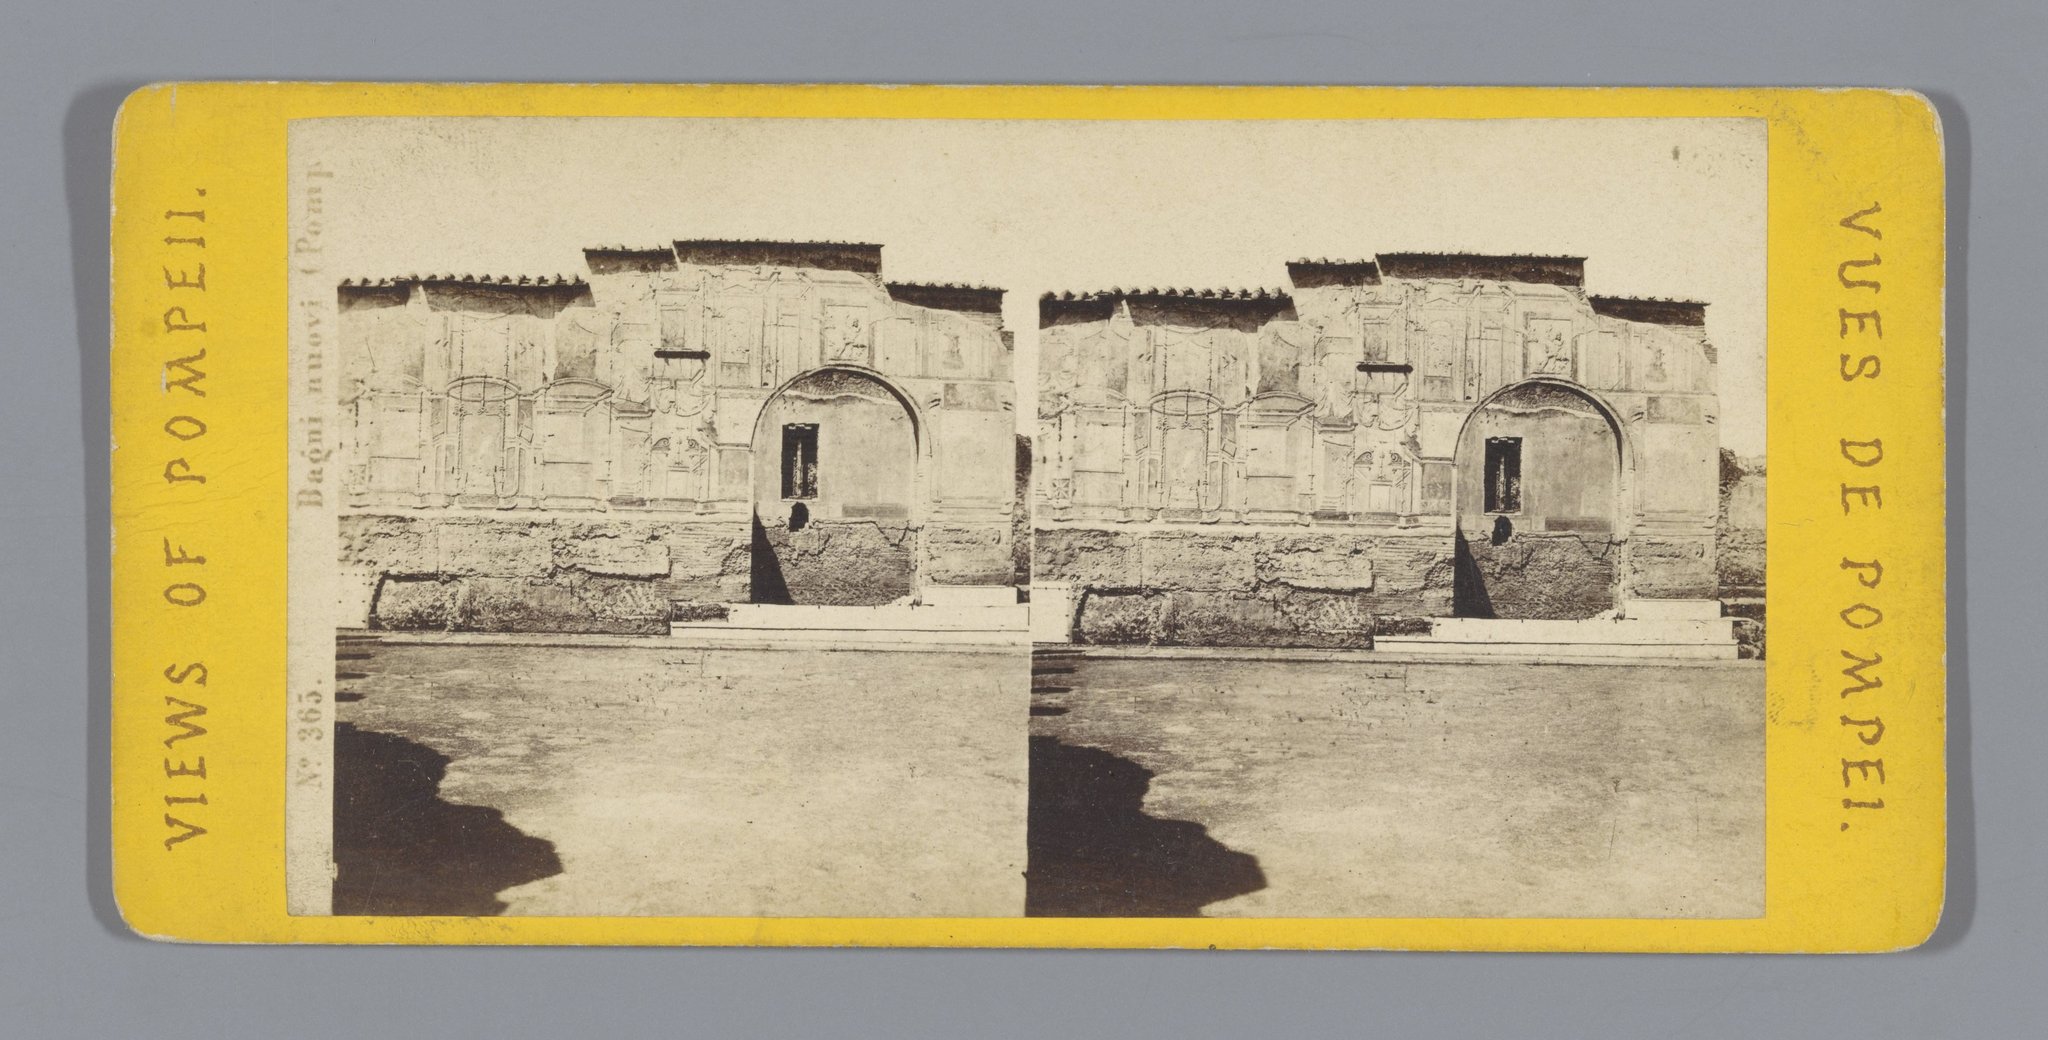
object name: stereograph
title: Bagni nuovi (Pomp[(...)]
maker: Anonymous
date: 1850-1880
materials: cardboard, photographic support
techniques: albumen print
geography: pompeii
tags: ruin of a building ~ architecture, public baths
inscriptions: inscription: ‘VIEWS OF POMPEII. VUES DE POMPEII.’, number: ‘No. 365.’